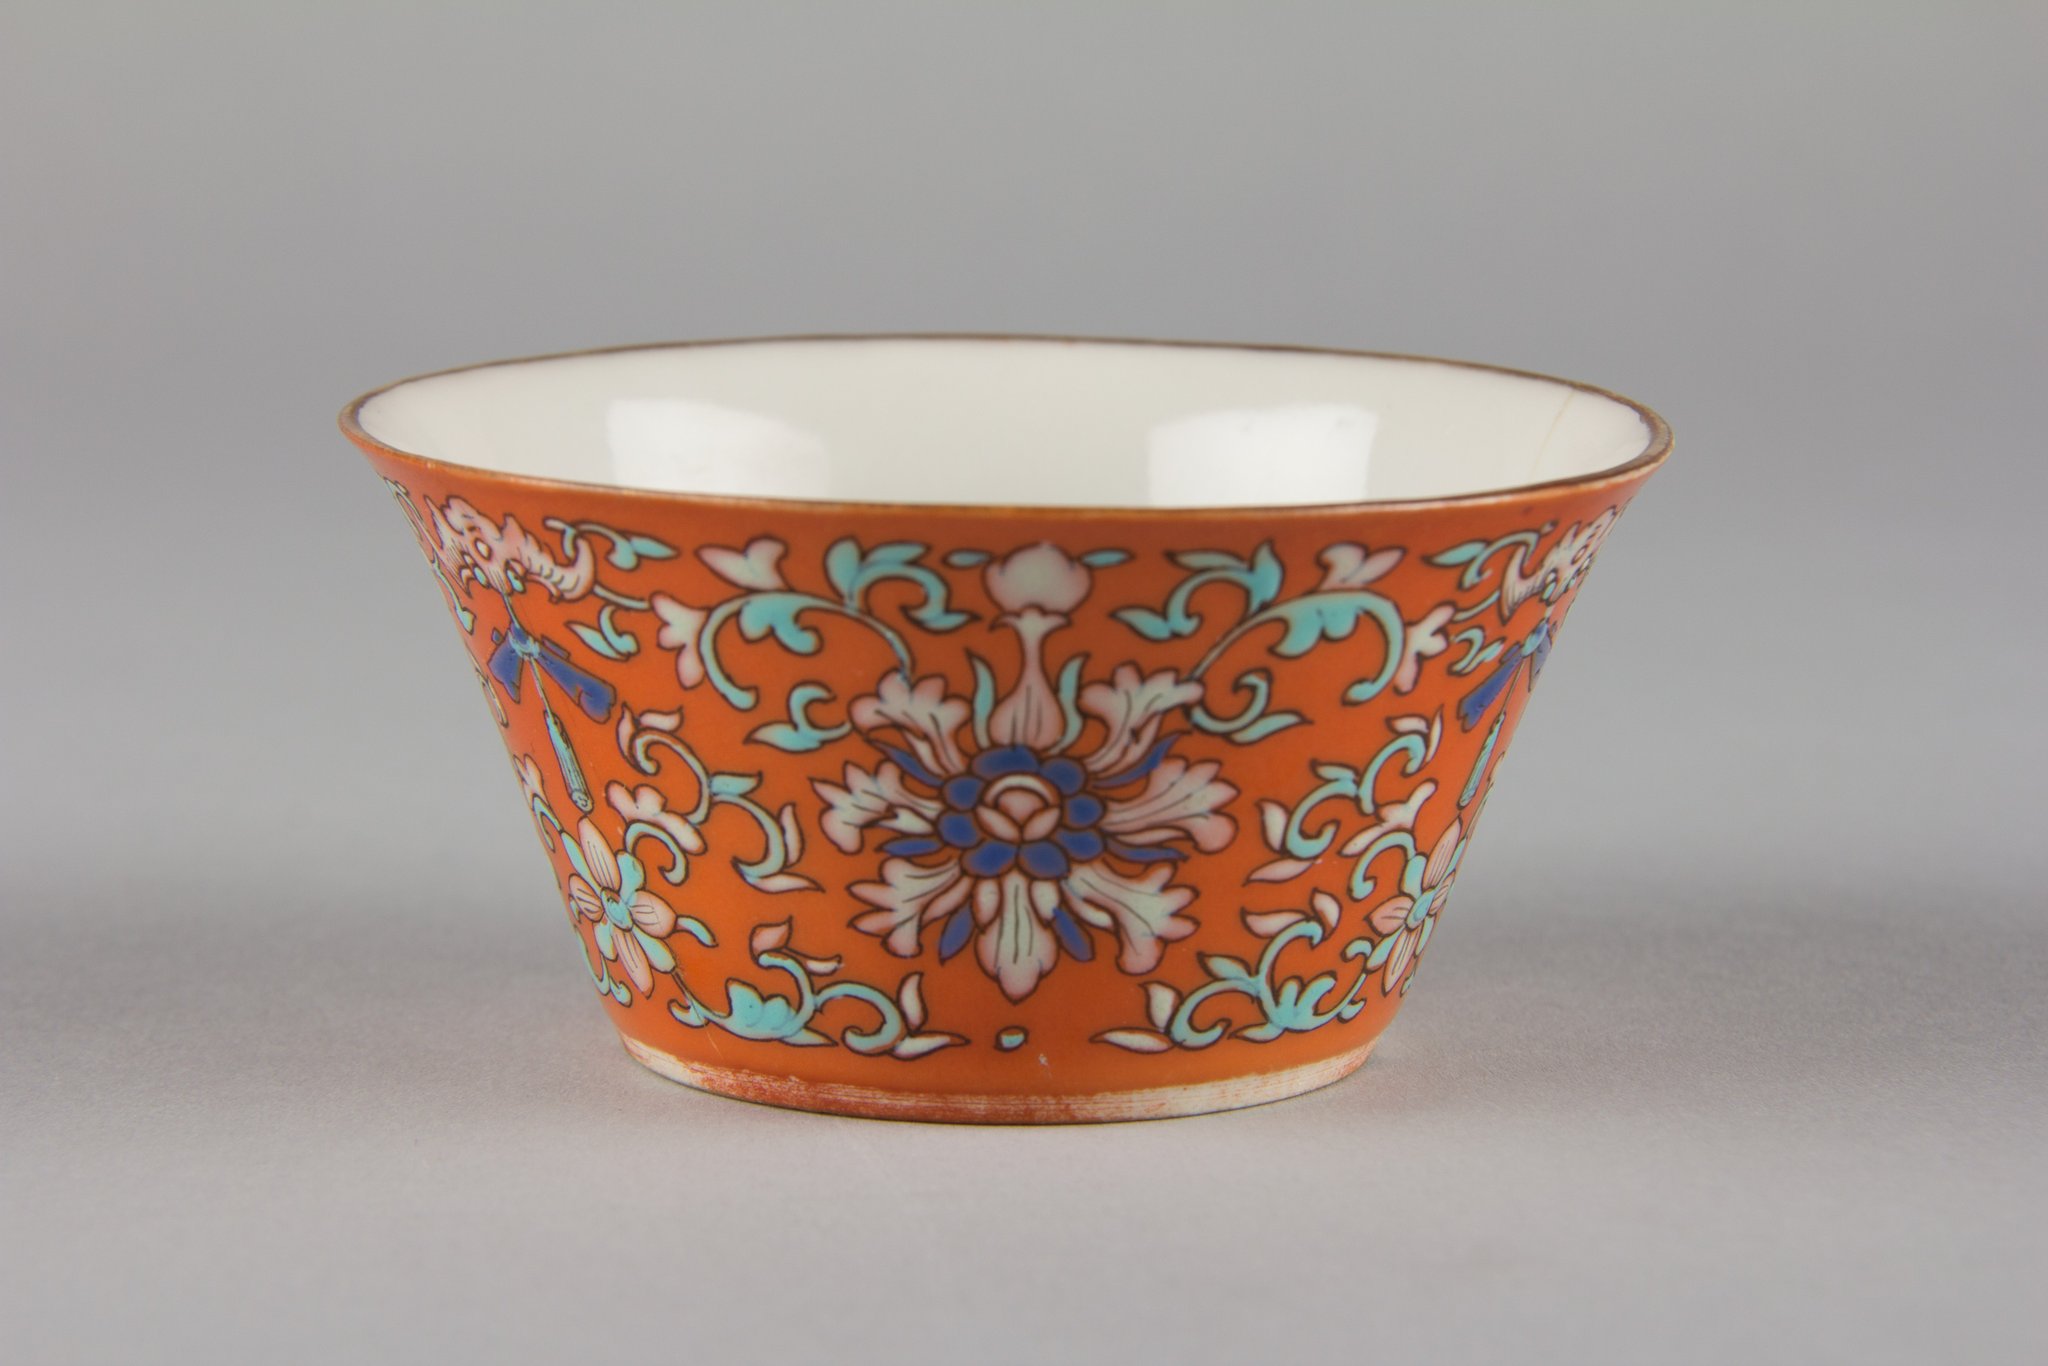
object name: cup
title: Cup (from a set of eight)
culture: chinese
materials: enamel, glaze, iron, porcelain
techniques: overglaze, painting, polychrome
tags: flowers